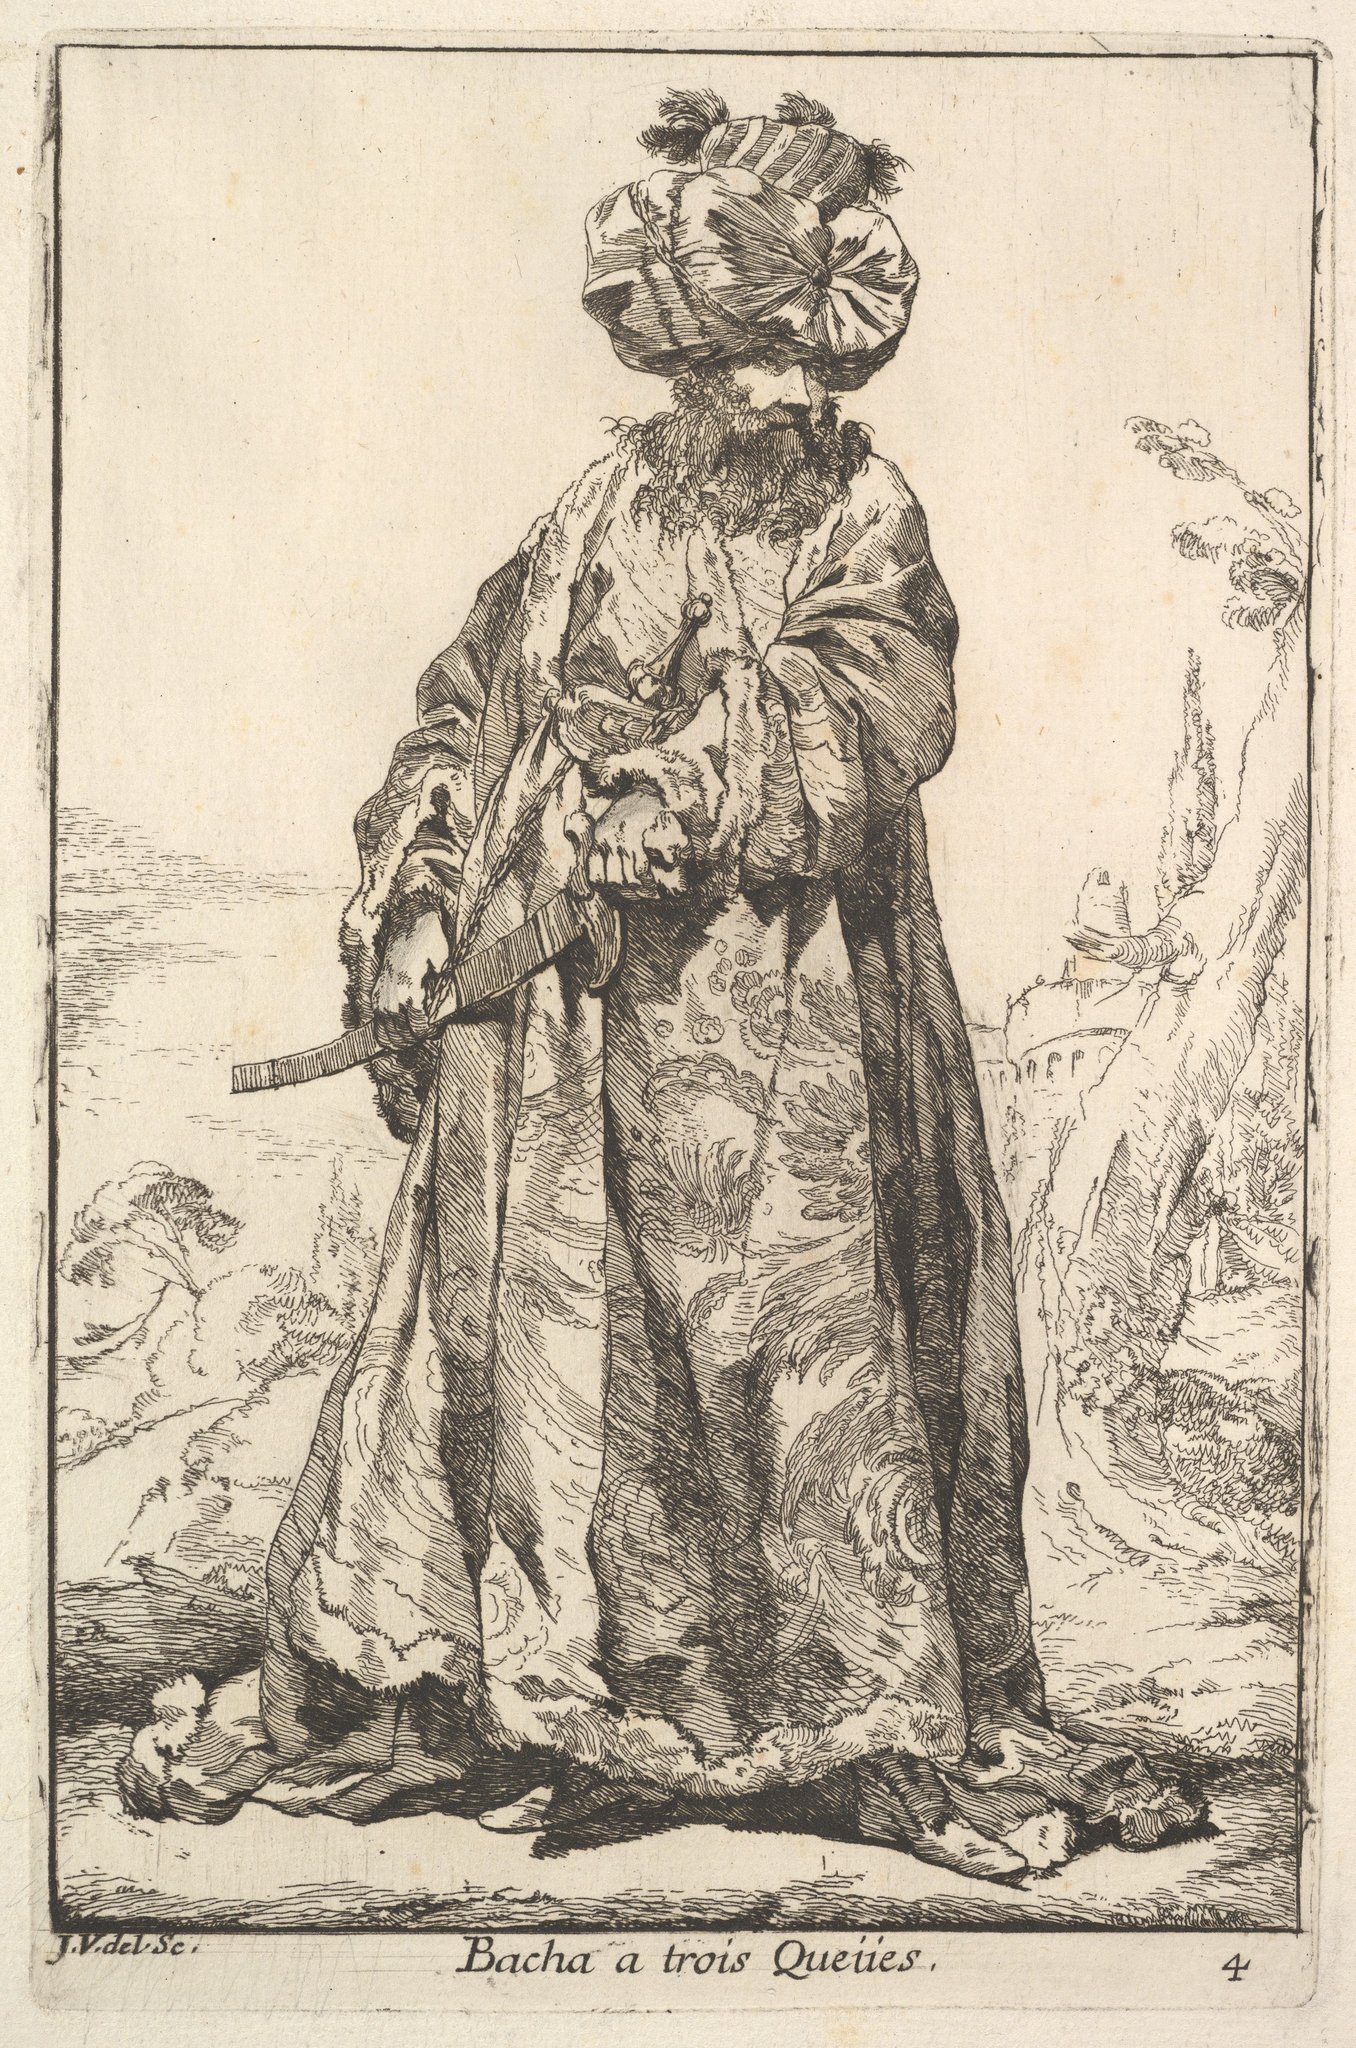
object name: print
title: Pasha grasping a sword at his hip with both hands, from "Caravan of the Sultan to Mecca" (Caravane du Sultan à la Mecque)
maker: joseph marie vien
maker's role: artist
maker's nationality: french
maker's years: 1716-1809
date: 1748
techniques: etching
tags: swords,men,portraits